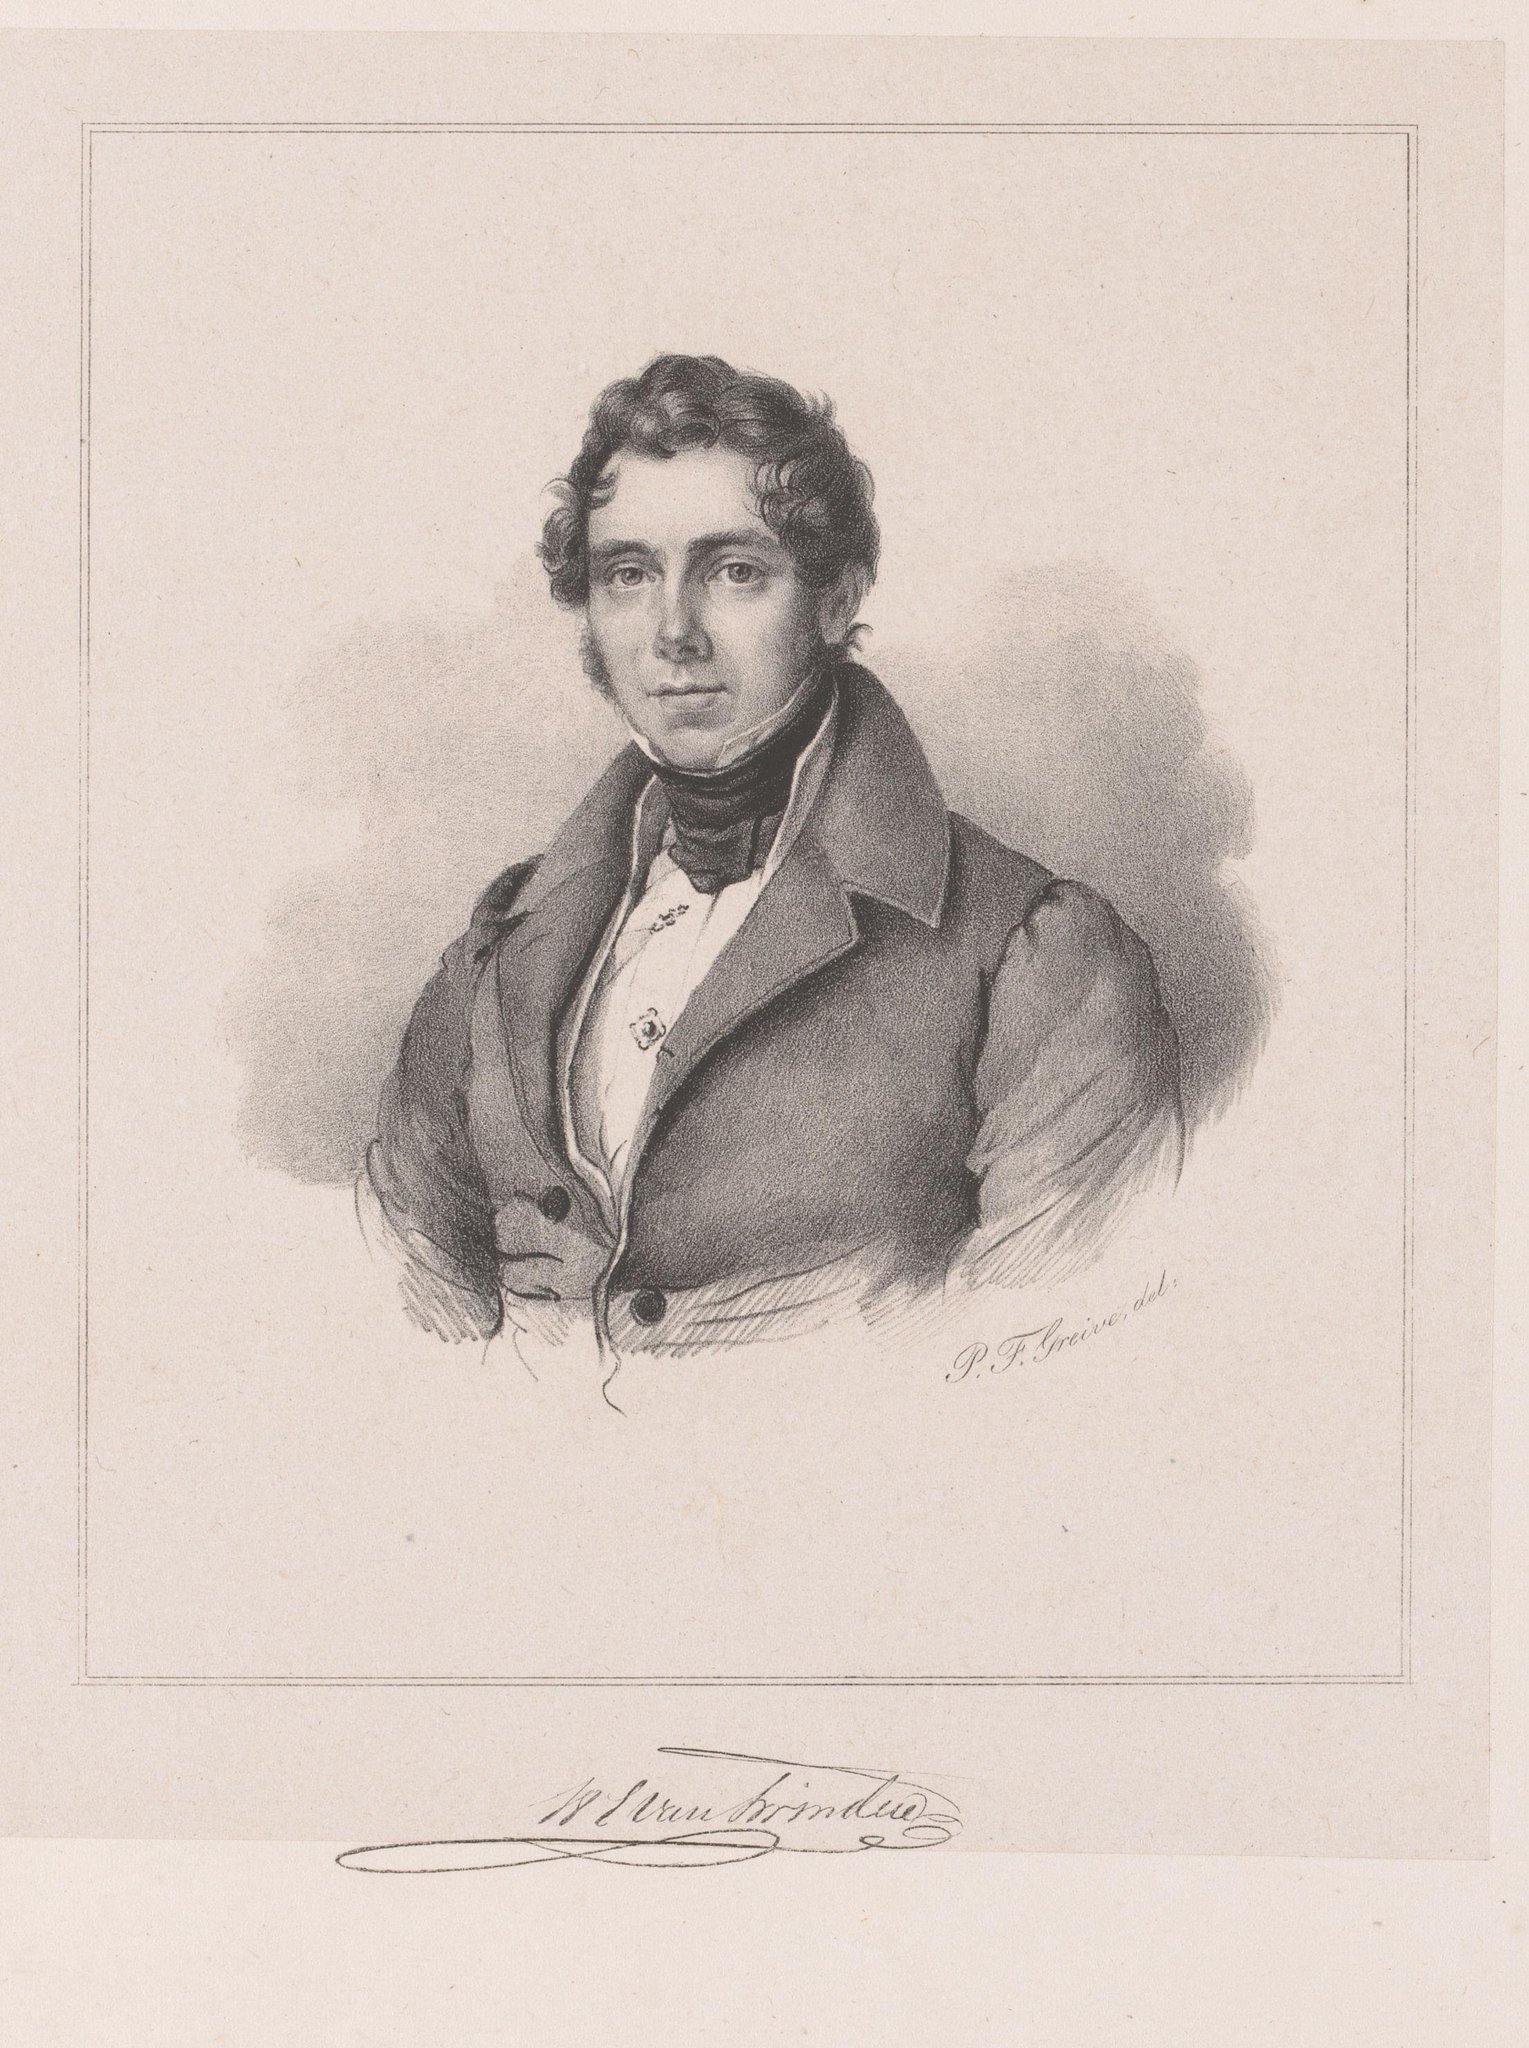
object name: print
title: Portret van Henri Etienne van Swinden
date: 1821-1836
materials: paper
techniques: lithograph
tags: amsterdam, historical persons (+ (full) bust portrait)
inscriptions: collector's mark: Lugt 2228